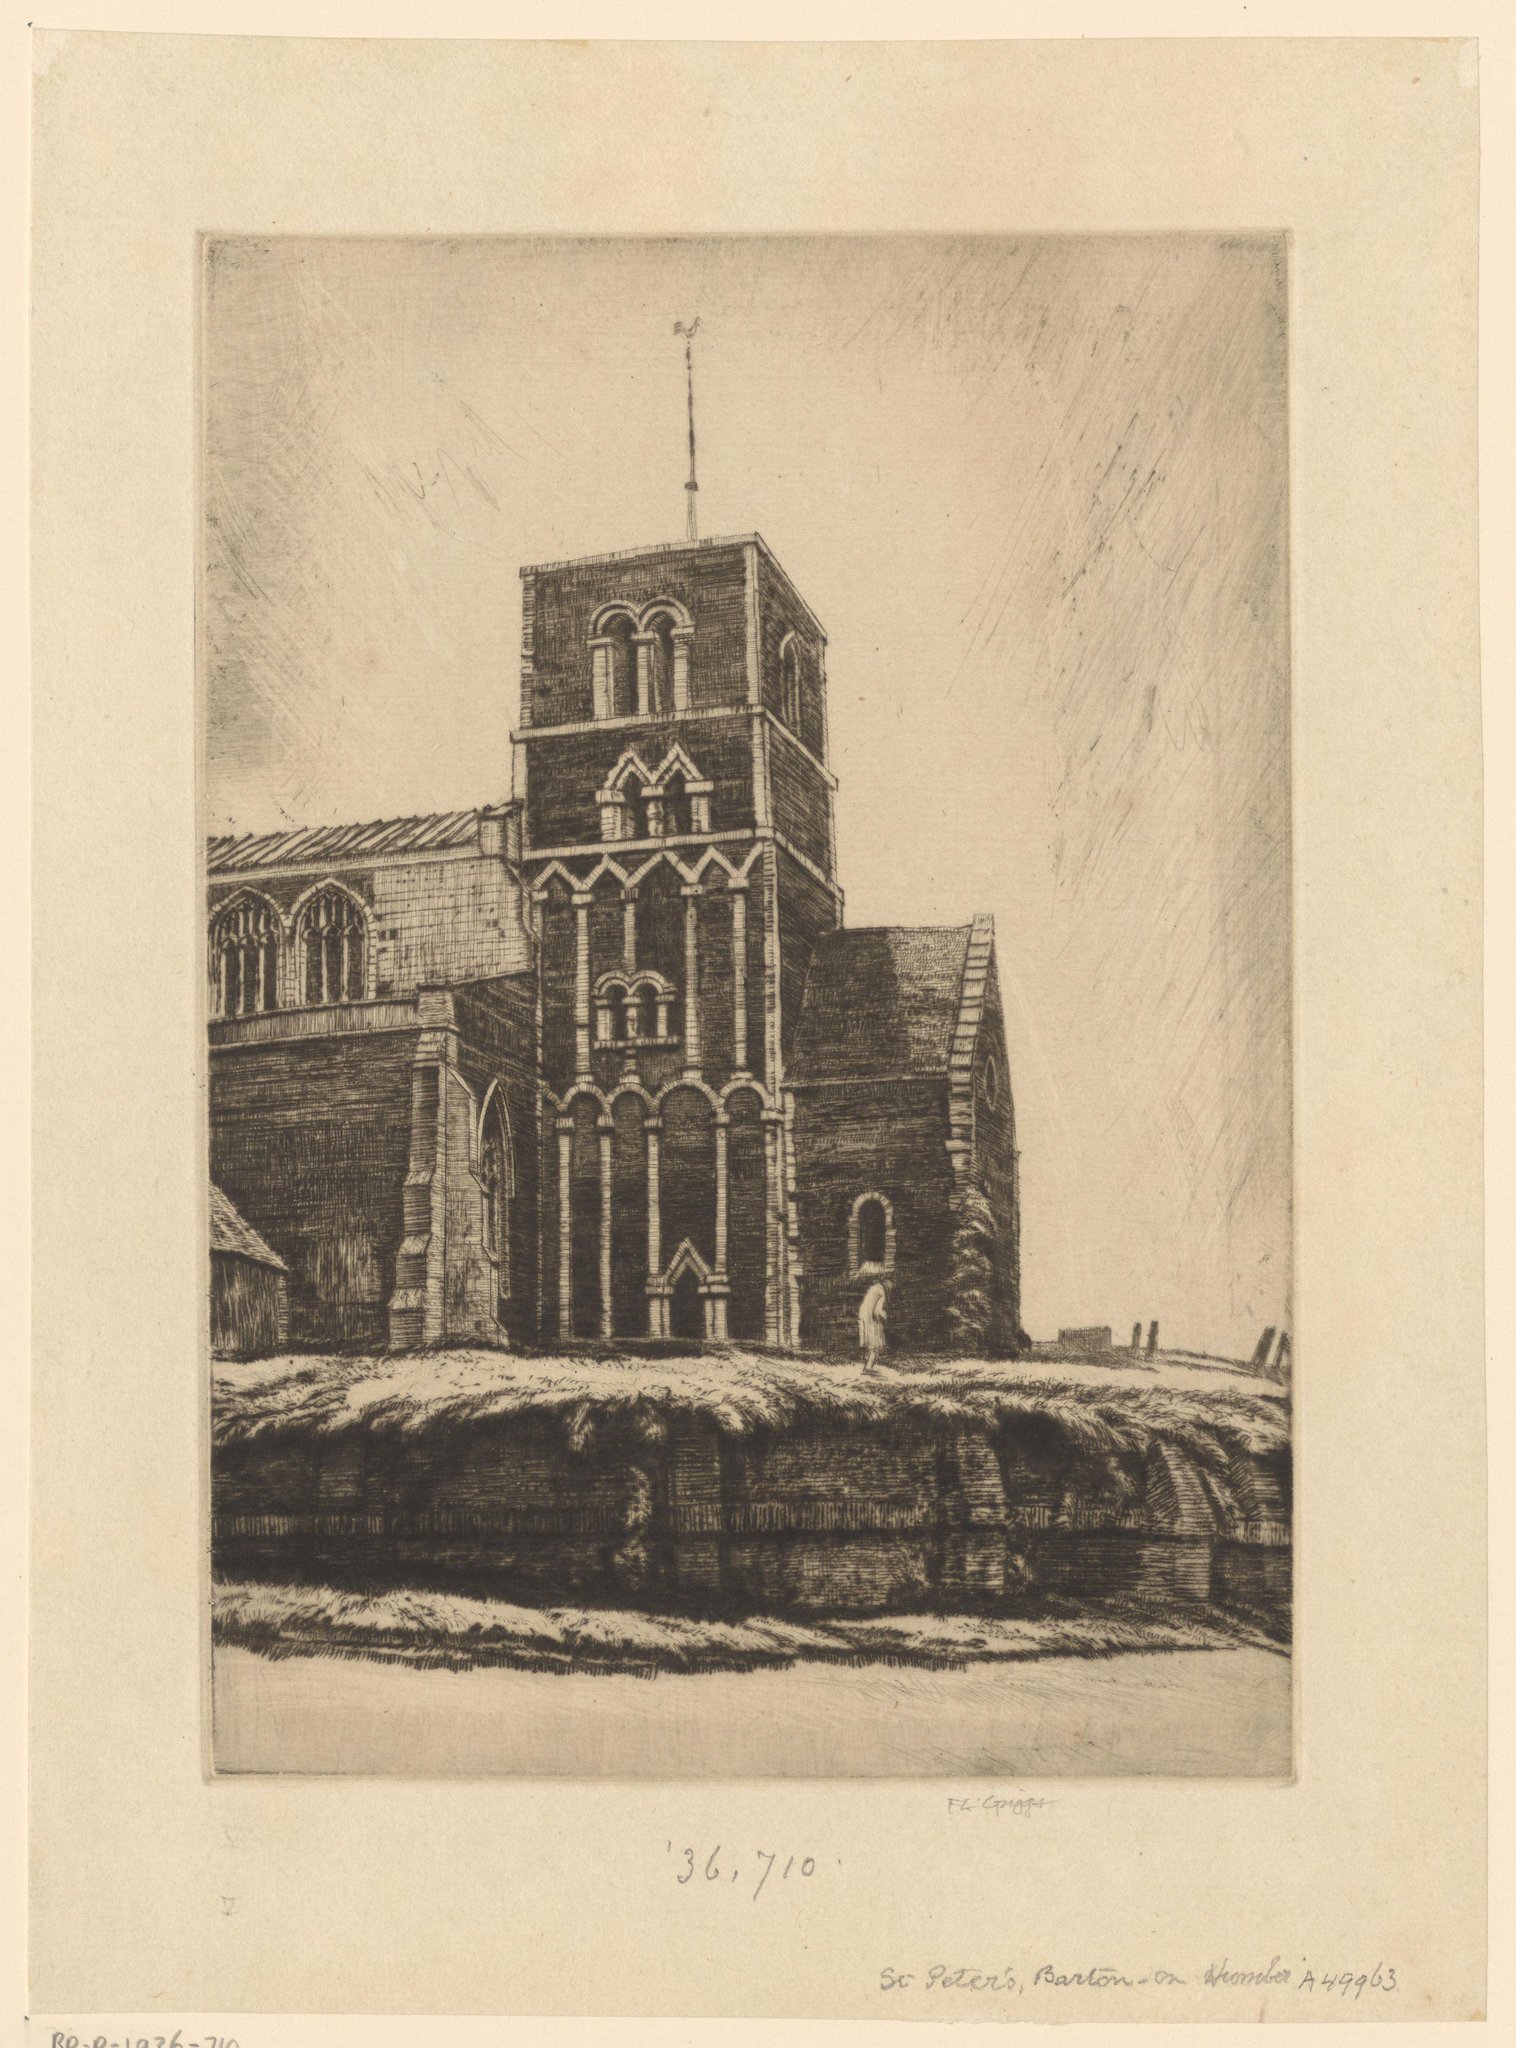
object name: print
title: Gezicht op de Petruskerk in Barton-upon-Humber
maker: frederick landseer maur griggs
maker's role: print maker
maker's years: 1876-1938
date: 1928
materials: paper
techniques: drypoint, intaglio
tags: church (exterior)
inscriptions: collector's mark: Lugt 2228, signature: ‘F.L. Griggs’